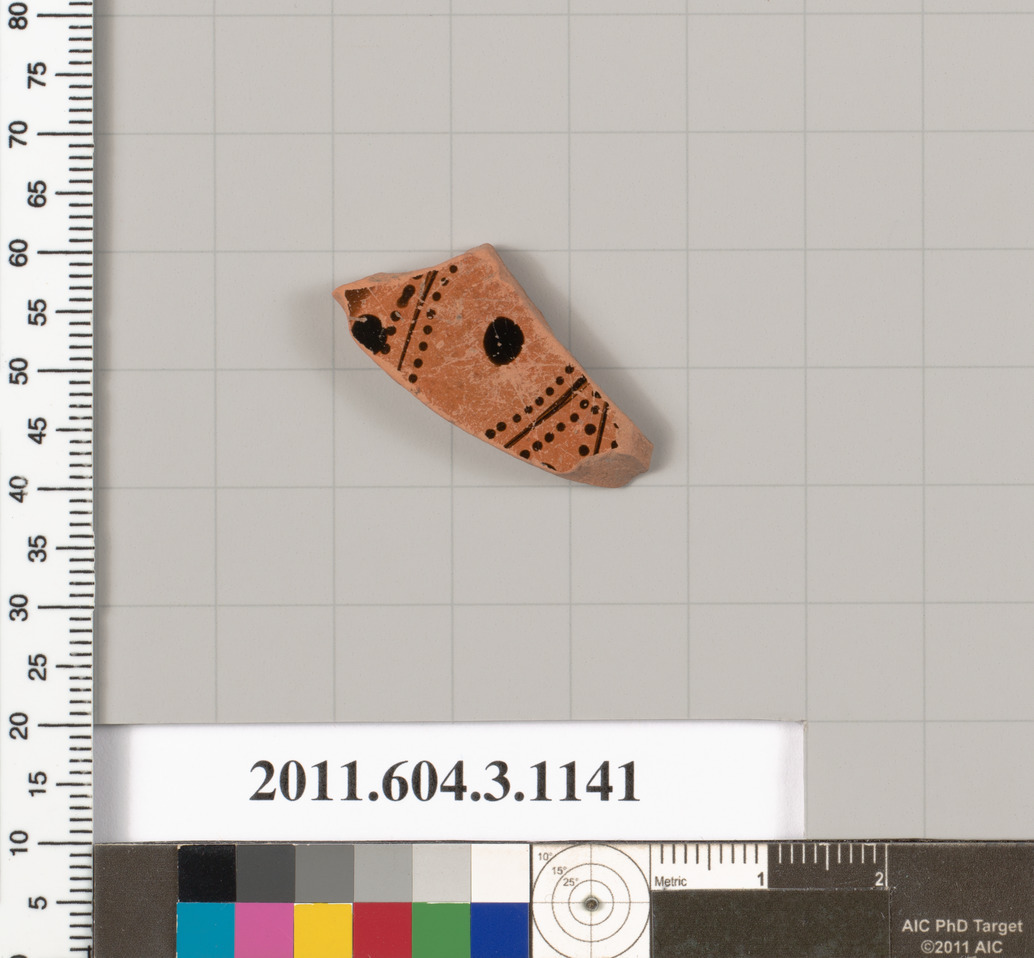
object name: mastoid or kyathos fragment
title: Terracotta fragment of a mastoid (drinking cup with narrow base) or a kyathos (cup-shaped ladle)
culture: greek, attic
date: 534-468 BCE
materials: terracotta